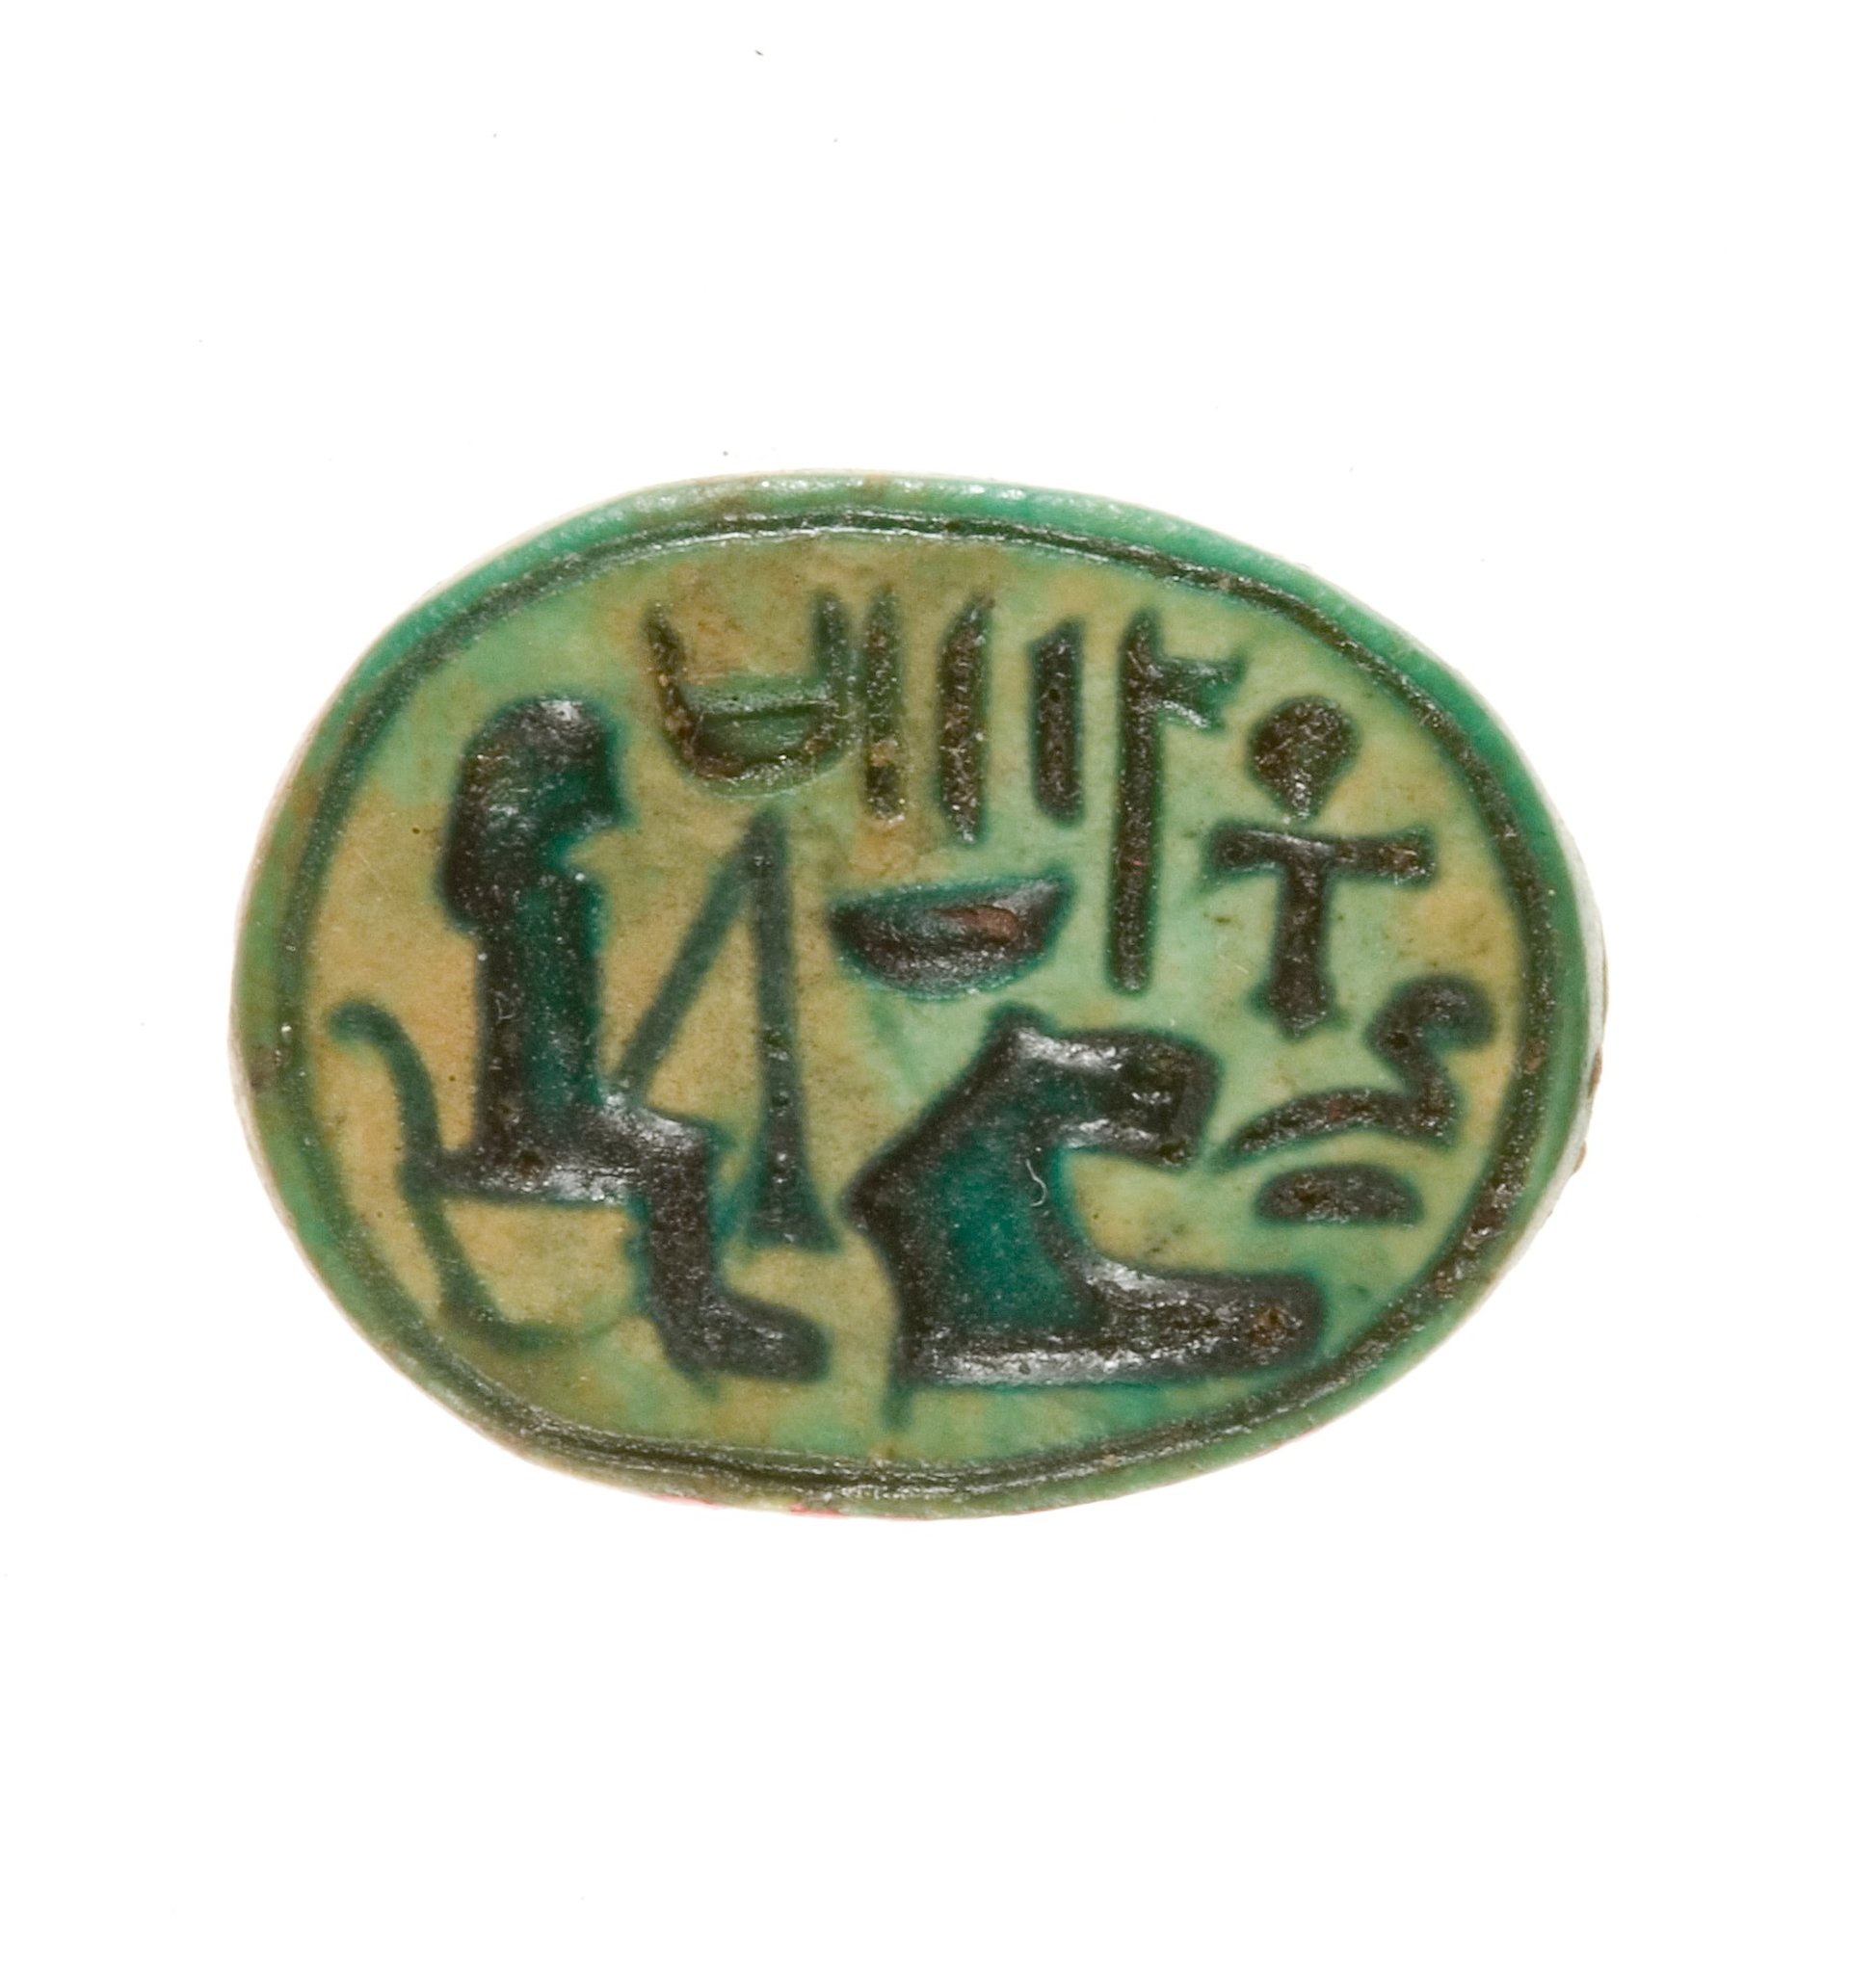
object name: scarab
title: Scarab Inscribed for the God's Wife Hatshepsut, Living Forever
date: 1479-1458 BCE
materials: stone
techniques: glazing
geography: egypt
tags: hieroglyphs,scarabs